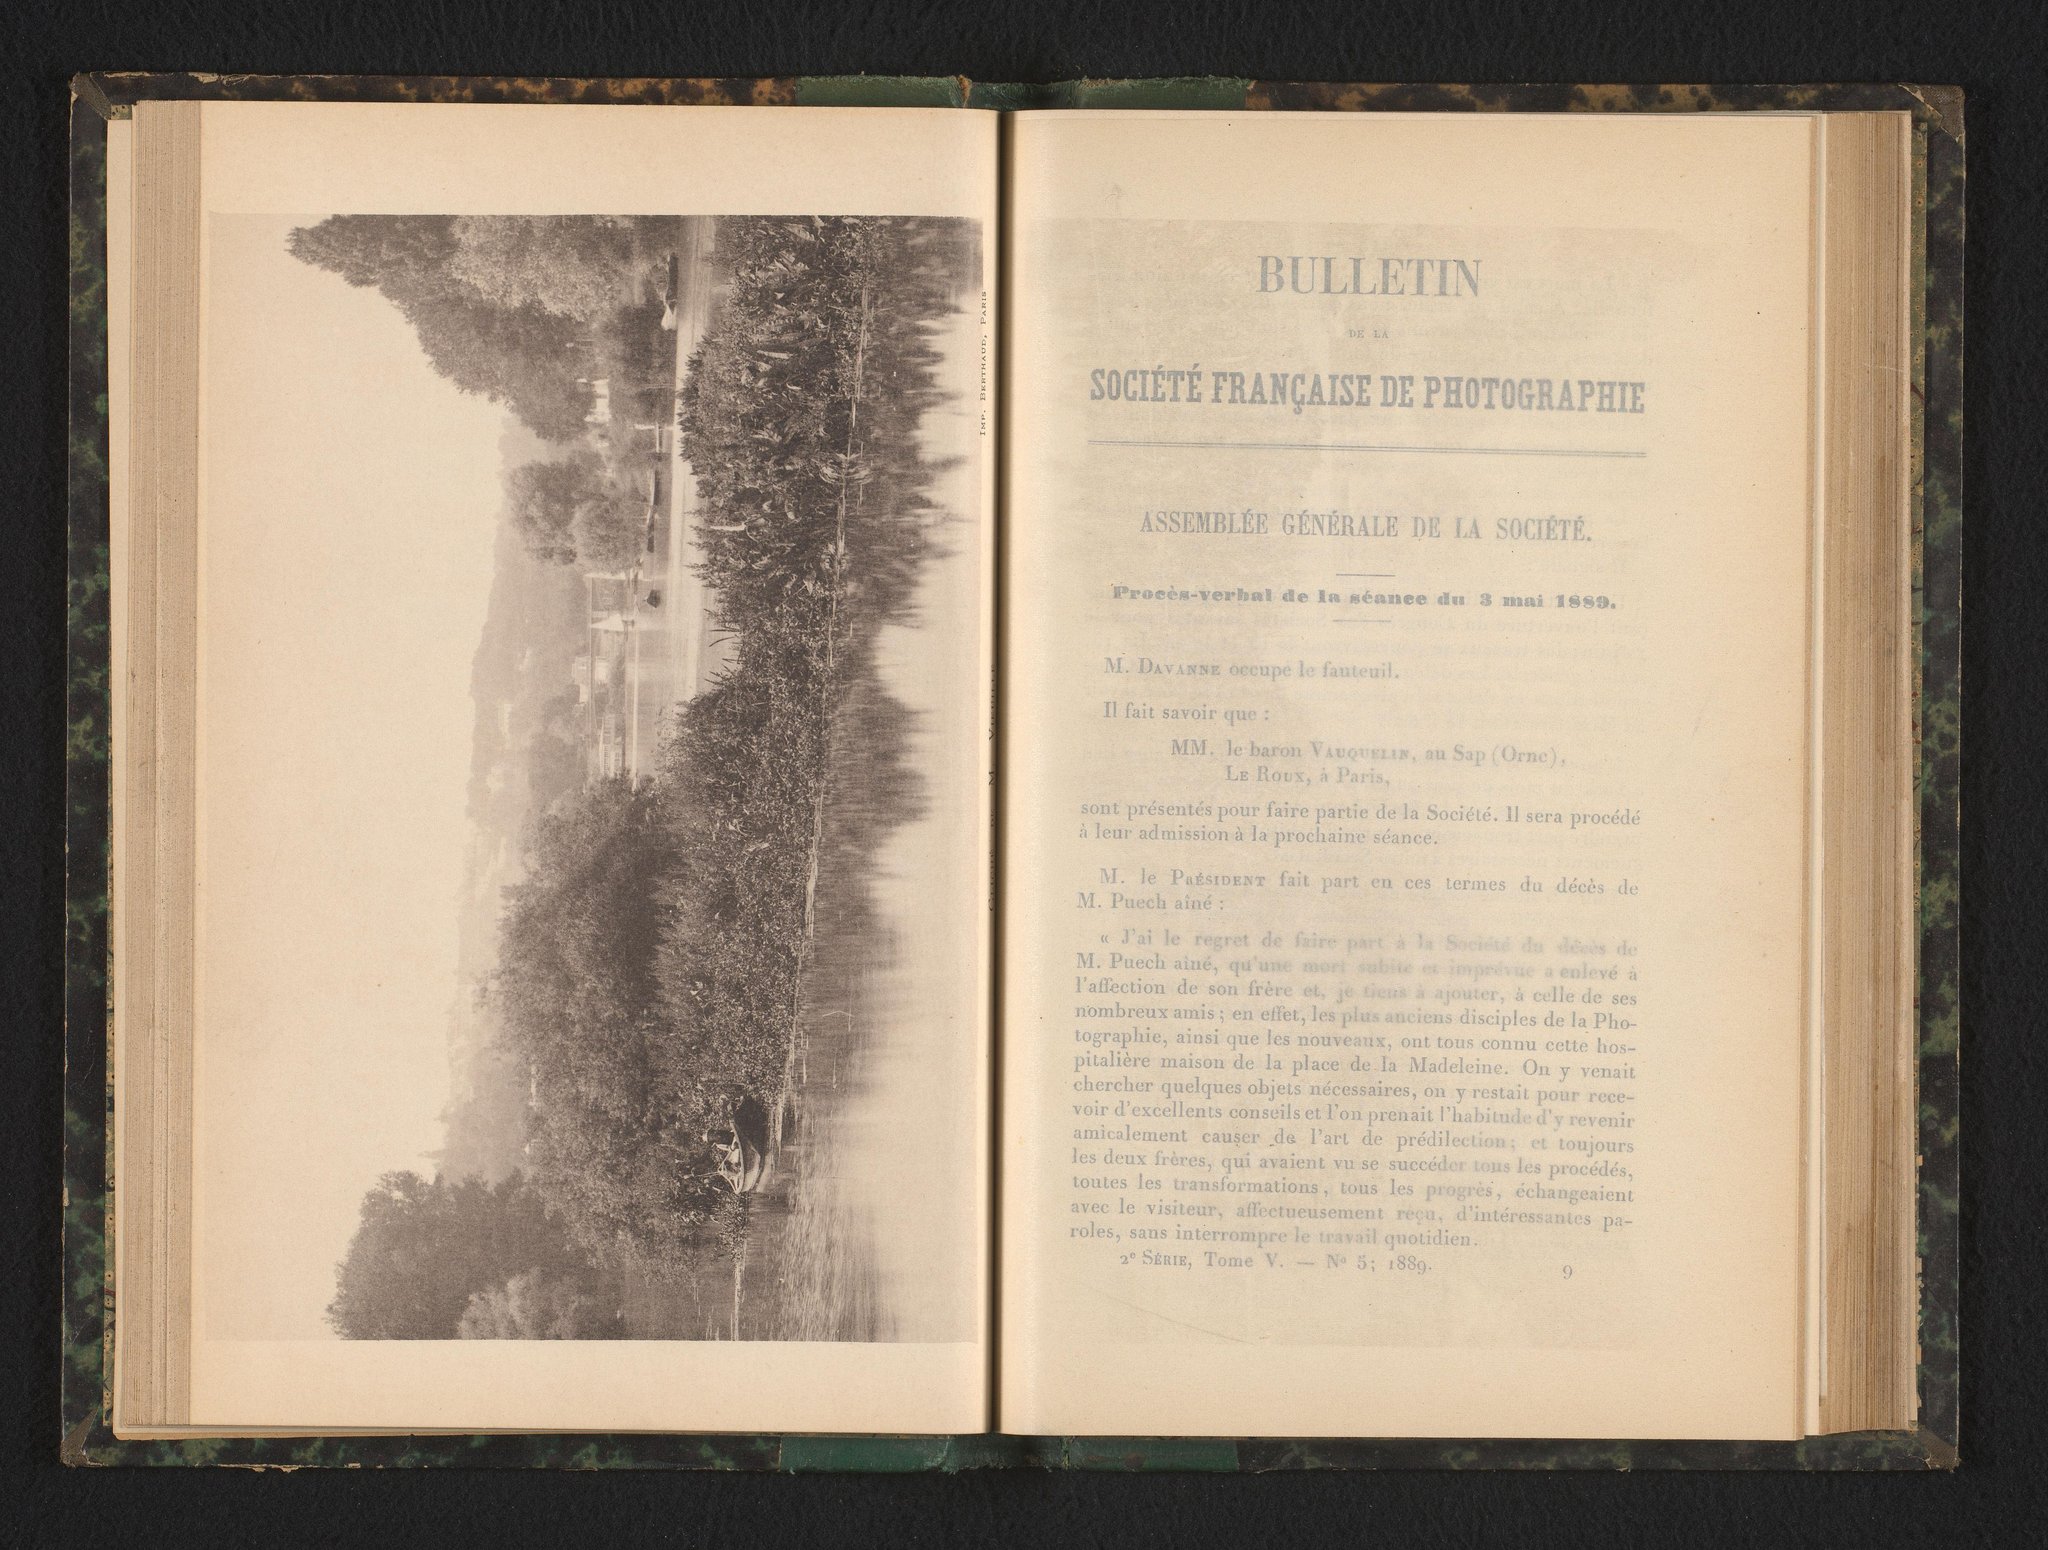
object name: photomechanical print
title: Mon Tour de Marne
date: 1884-1889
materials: paper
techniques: photoaquatint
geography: marne river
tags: river, shrubs